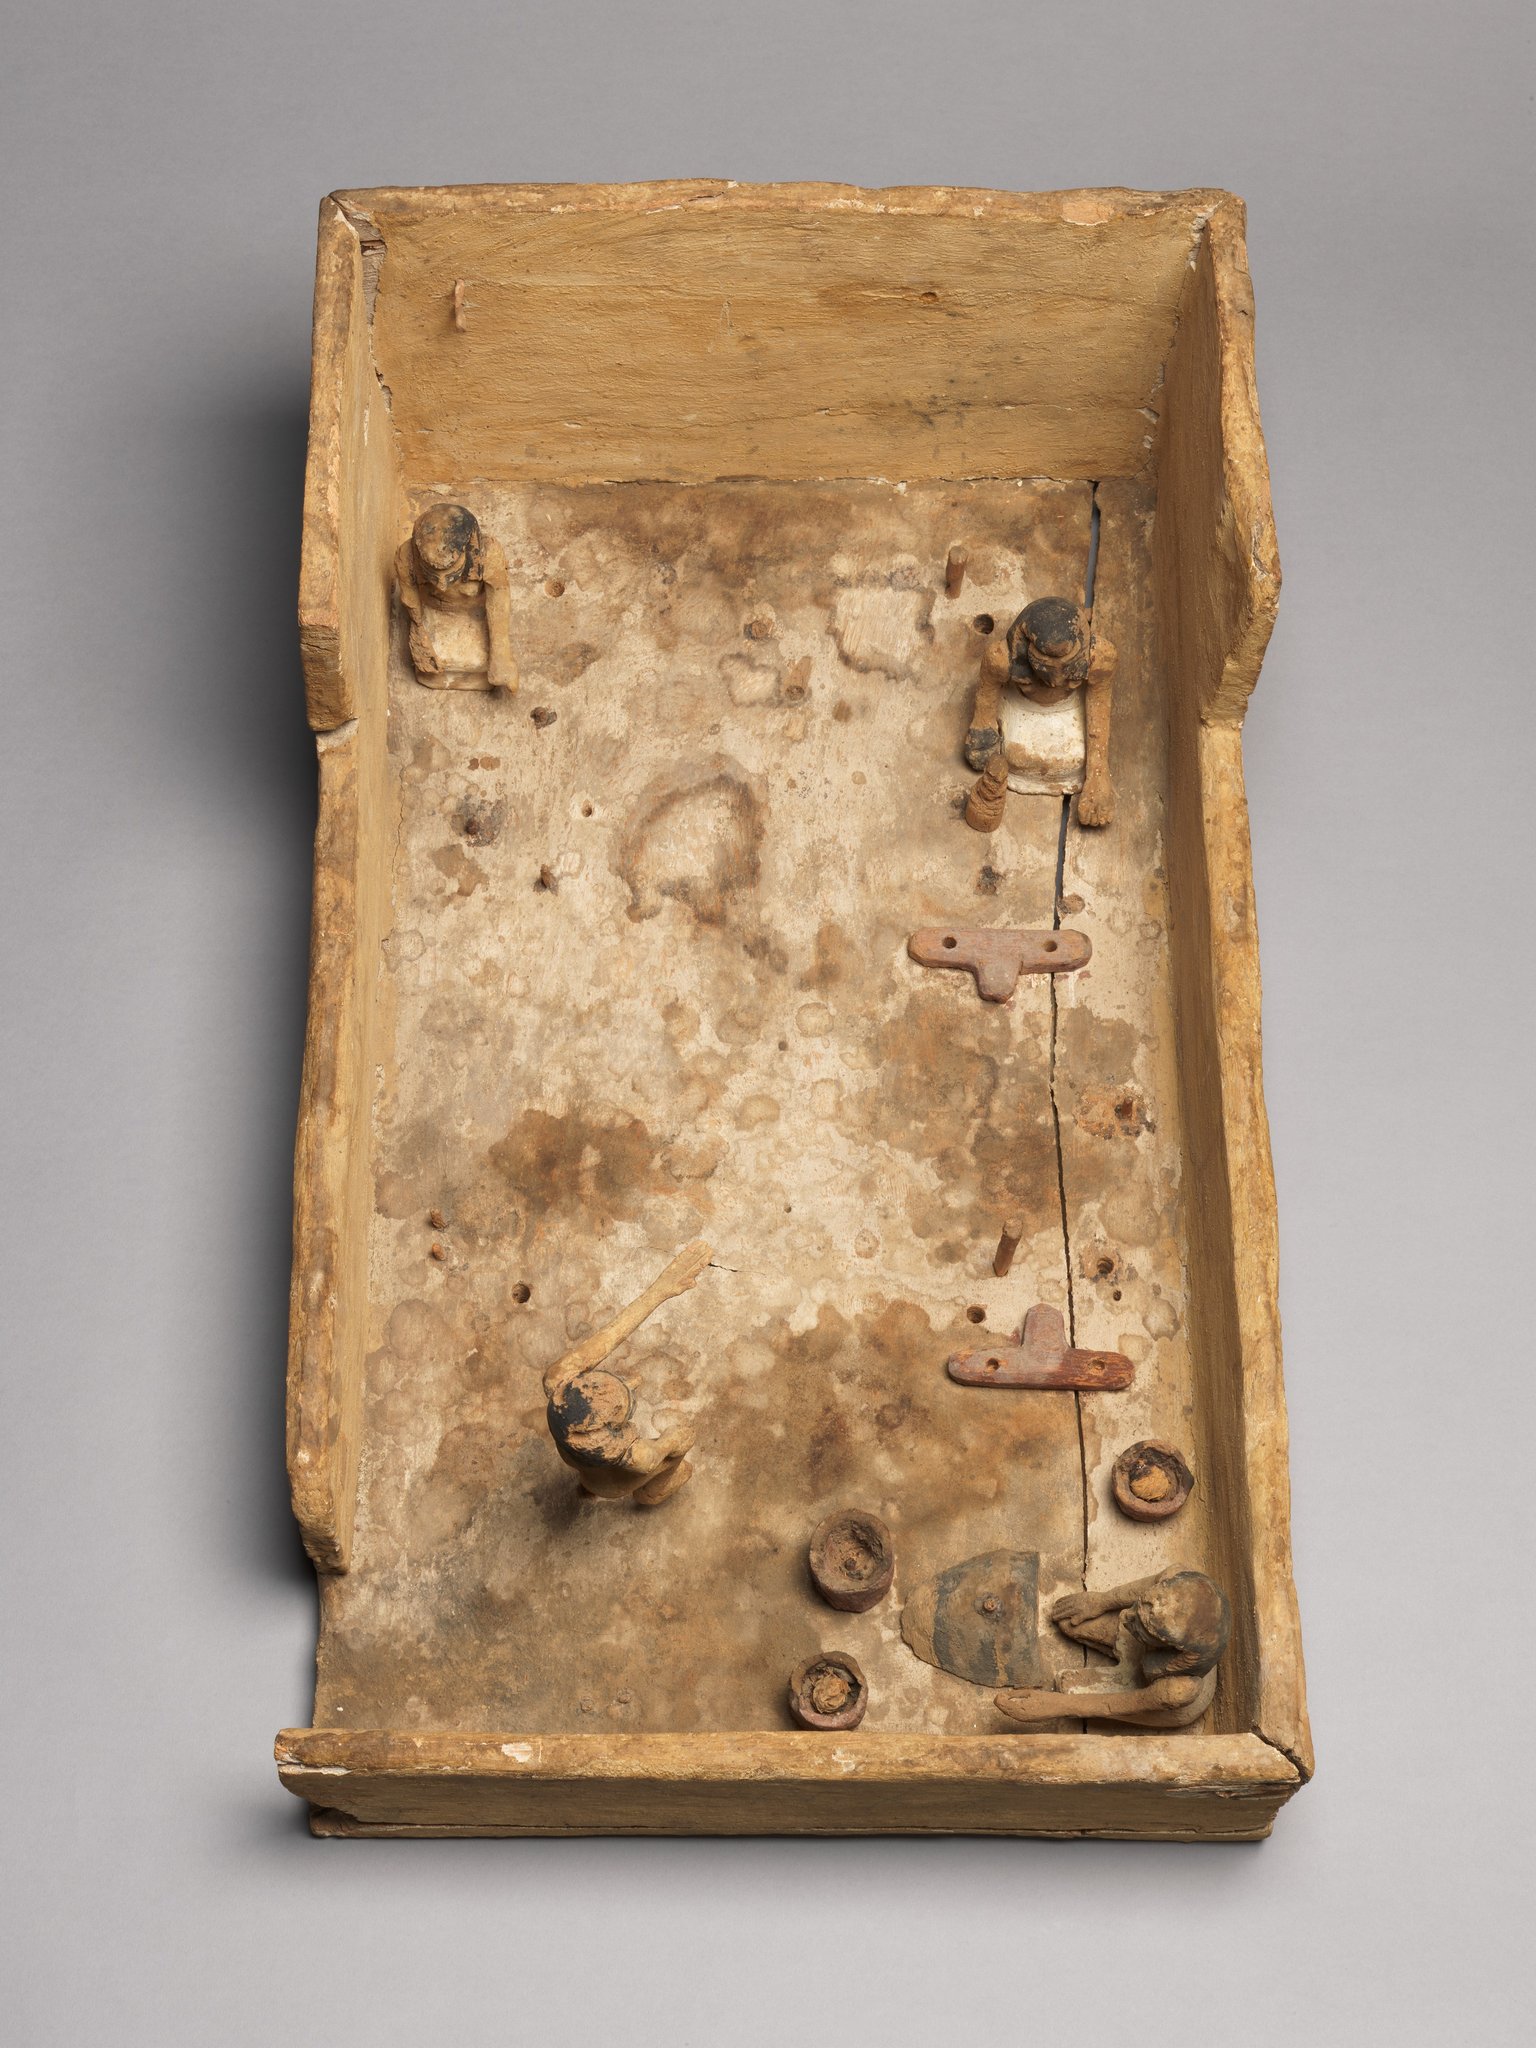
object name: model, weaver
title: Fragmentary Model of a Weavers Shop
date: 2030-1640 BCE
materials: gesso, paint, wood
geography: northern upper egypt